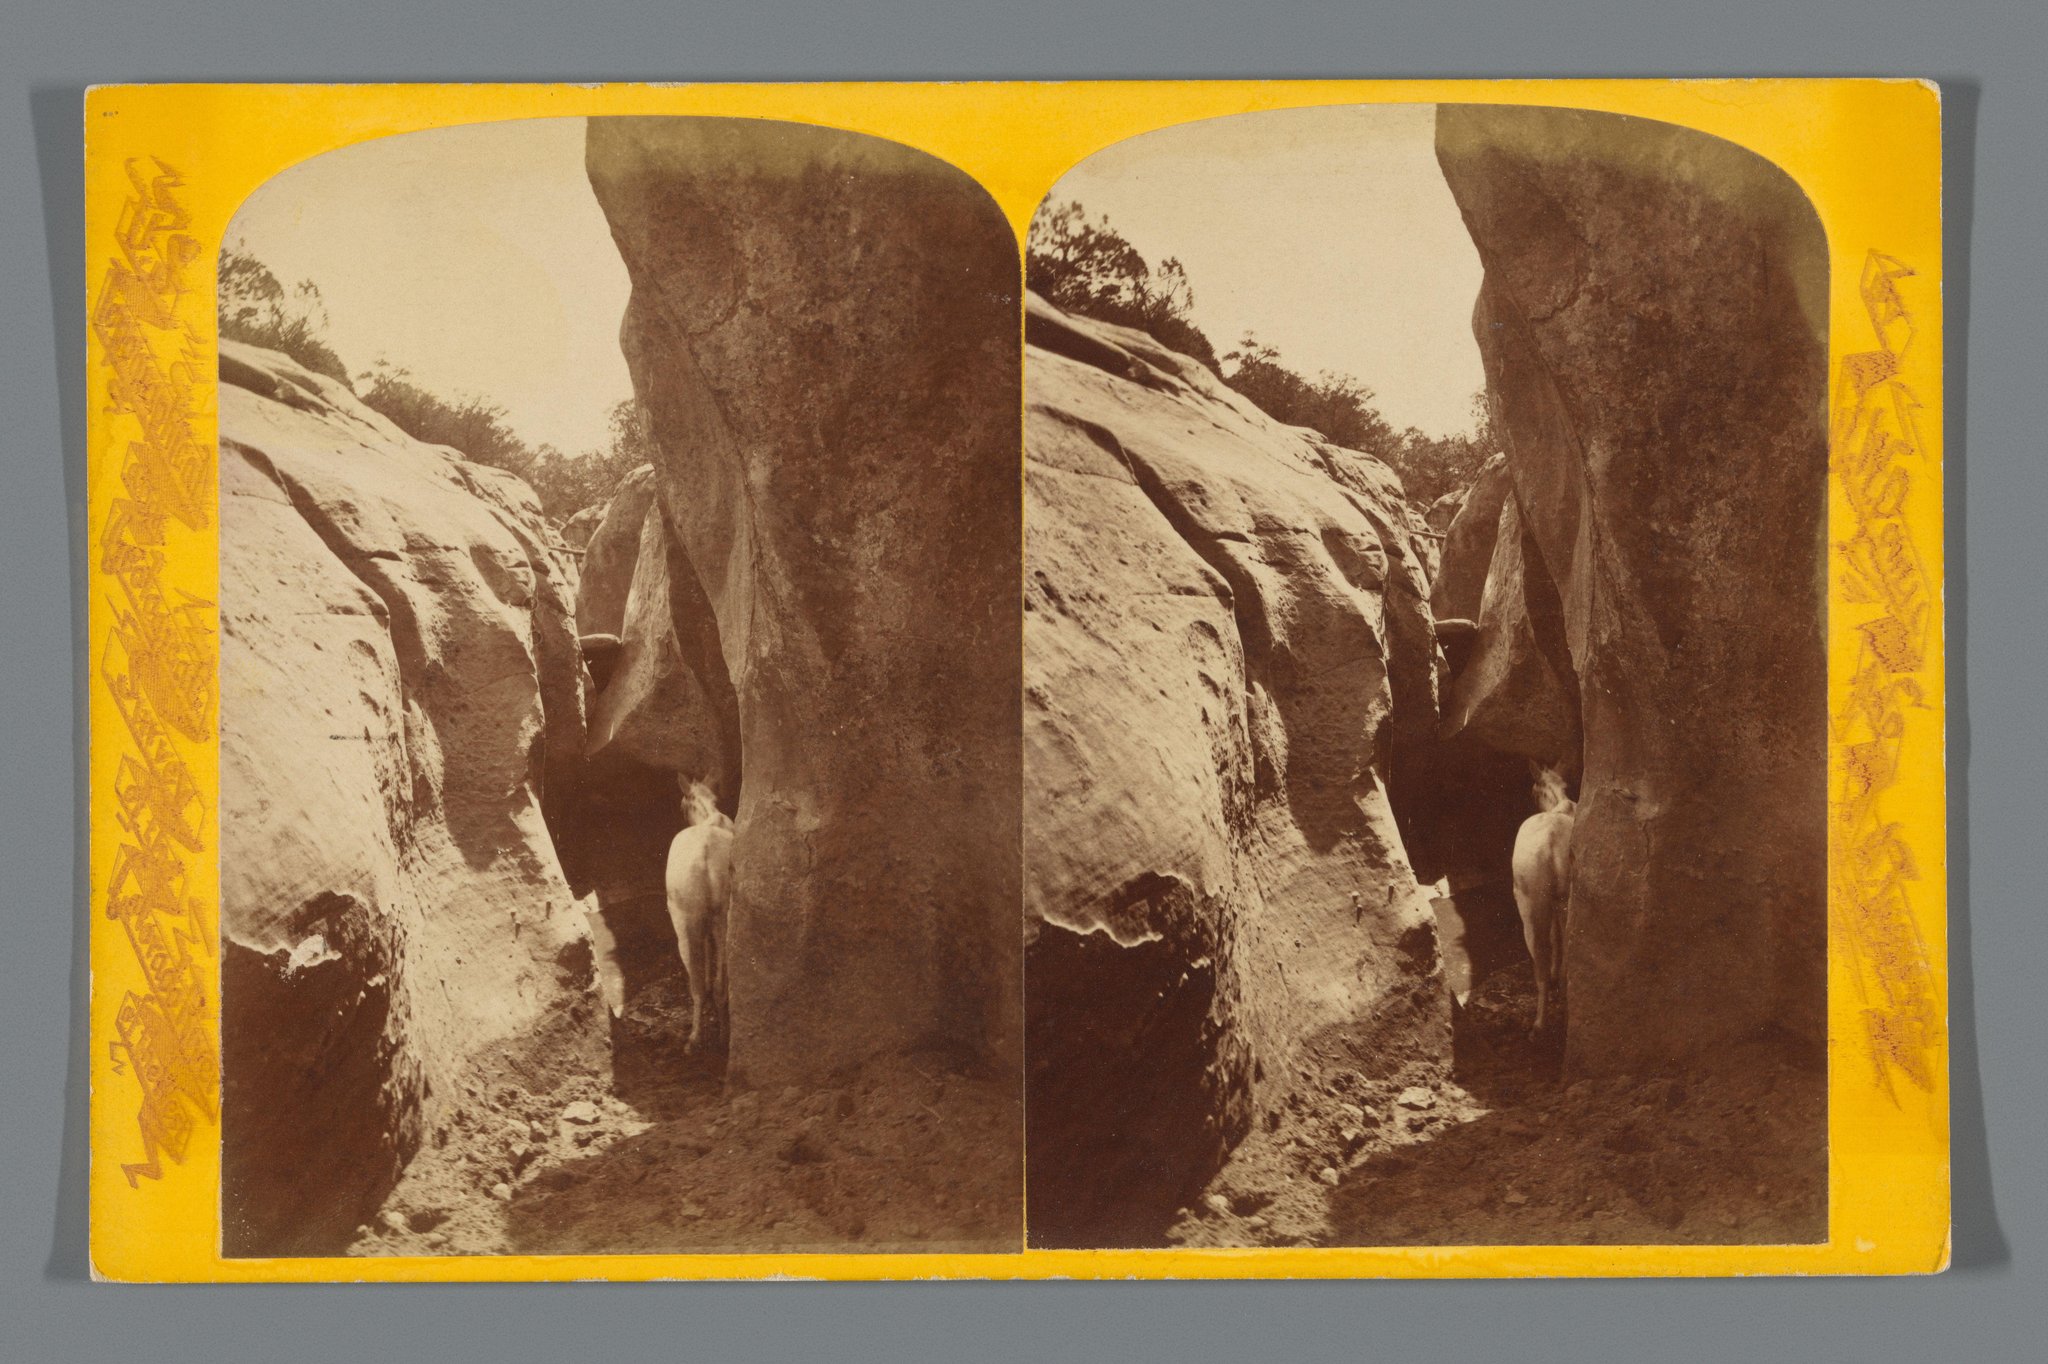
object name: photograph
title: Views on the Kai-Par-O-Wits Plateau, photographed for John Powell's U.S. Geological and Geographical Survey of the Terretories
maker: john karl hillers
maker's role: fotograaf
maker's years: 1843-1925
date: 1875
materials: cardboard, photographic support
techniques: albumen print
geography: utah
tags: cave, grotto, horse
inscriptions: inscription: ‘(...)’